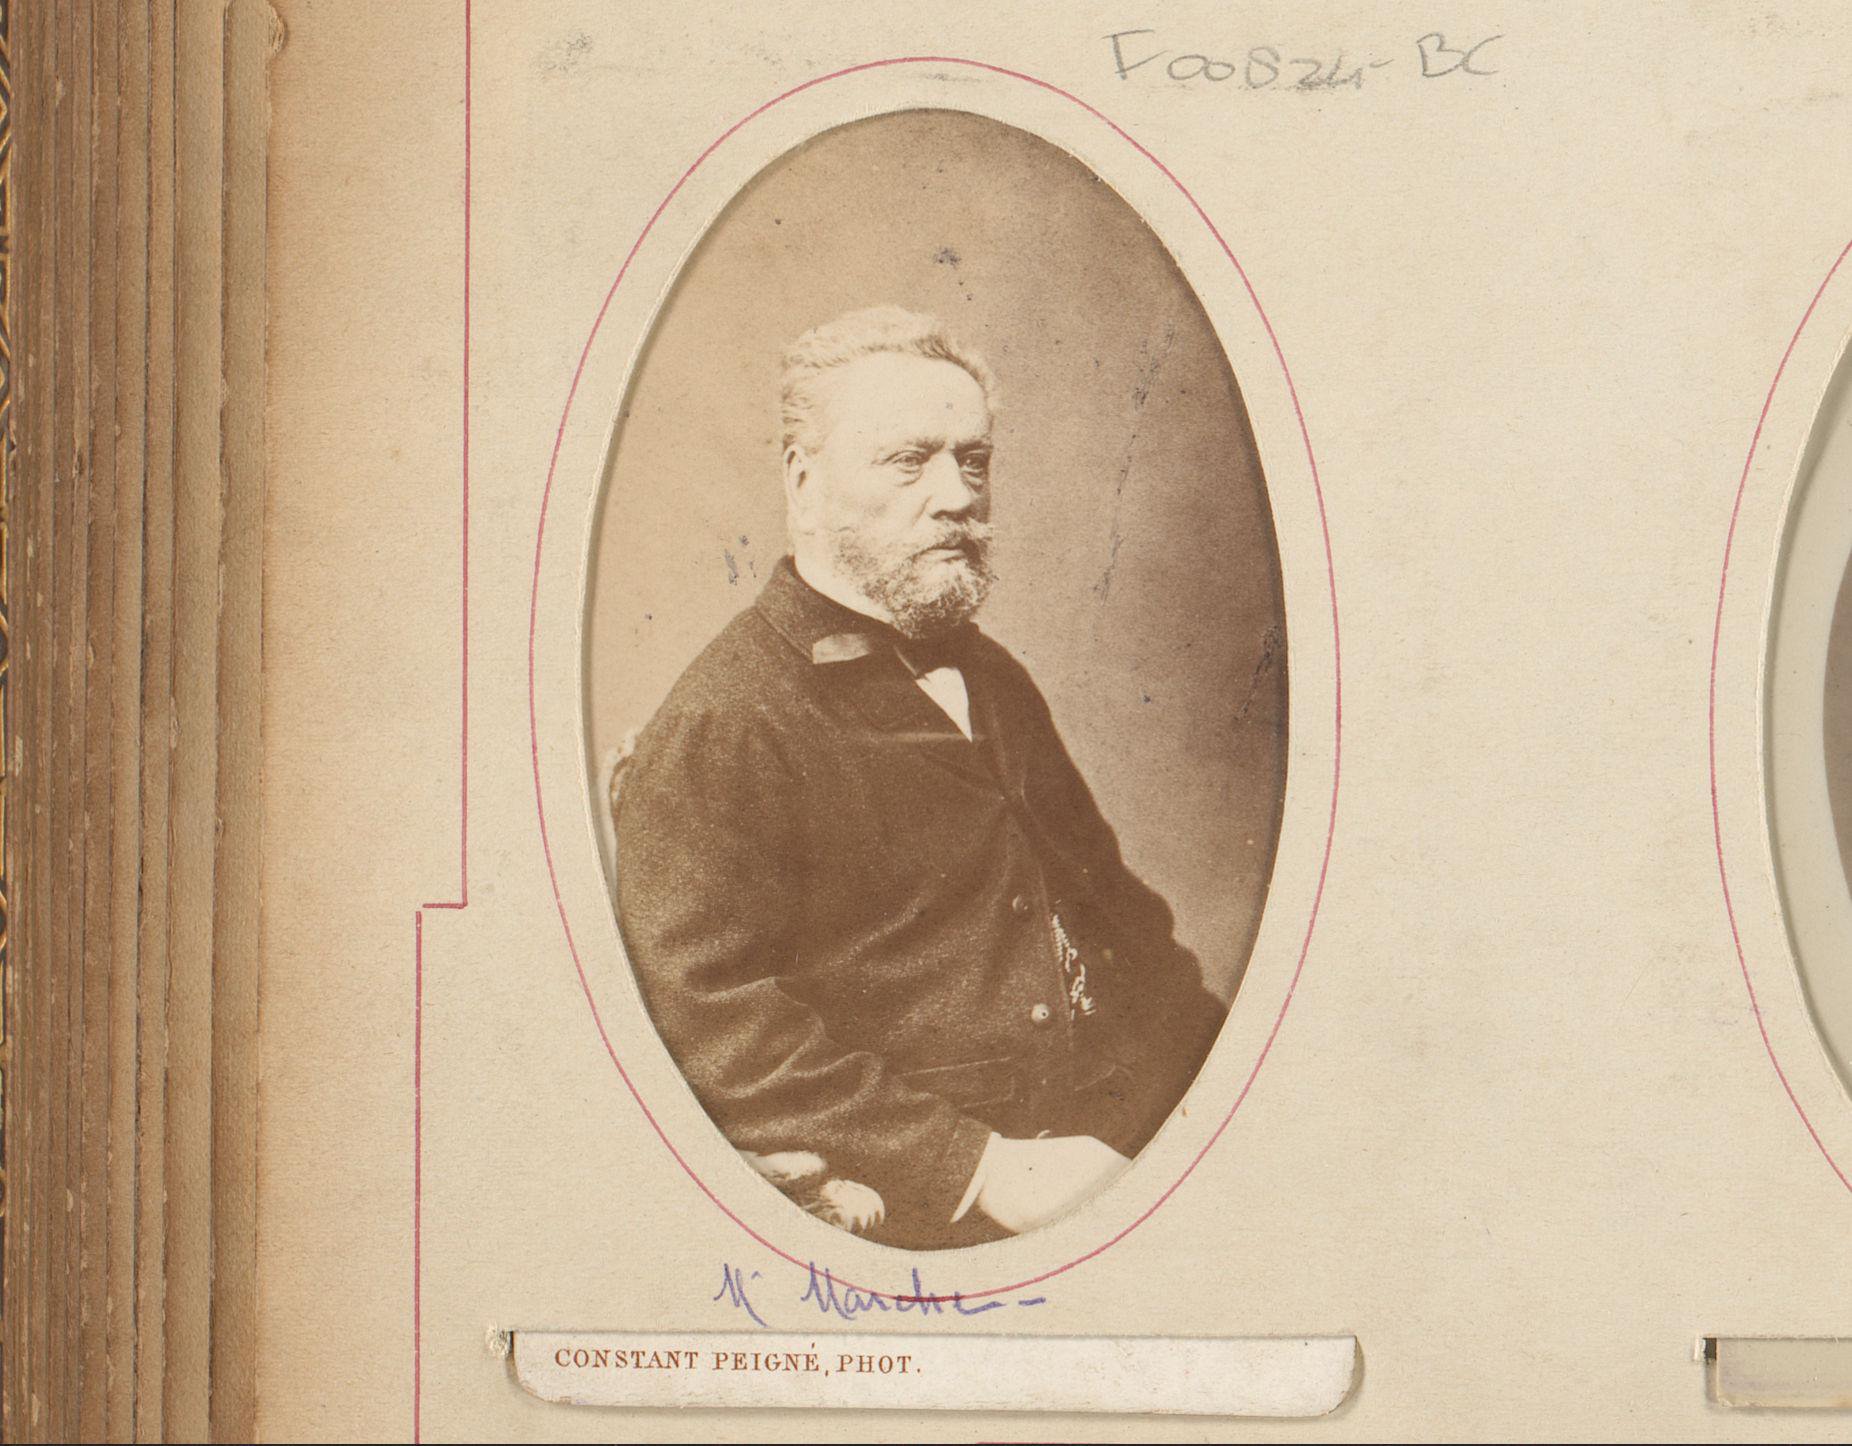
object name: photograph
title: Portret van een man, aangeduid als Mr. Marche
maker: constant peigné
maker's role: fotograaf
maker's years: 1834-1916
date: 1875-1879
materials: cardboard, paper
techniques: albumen print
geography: nantes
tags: adult man, anonymous historical person portrayed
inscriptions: inscription: ‘1XX PRIX/ MÉDILLE D'ARGENT/ BLOIS/ 1875/ BREVETÉ S.G.D.G/ No de Cliché 98471 [?]/ Pour avoir ce portrait sans poser, envoyer le No ci- dessus, la maison conserve les clichés indéfiniment’, address: ‘Rue Crébillon, 8,/ NANTES./ Succersale Rue de Nantes/ Maison Buisneau/ St. NAZAIRE’